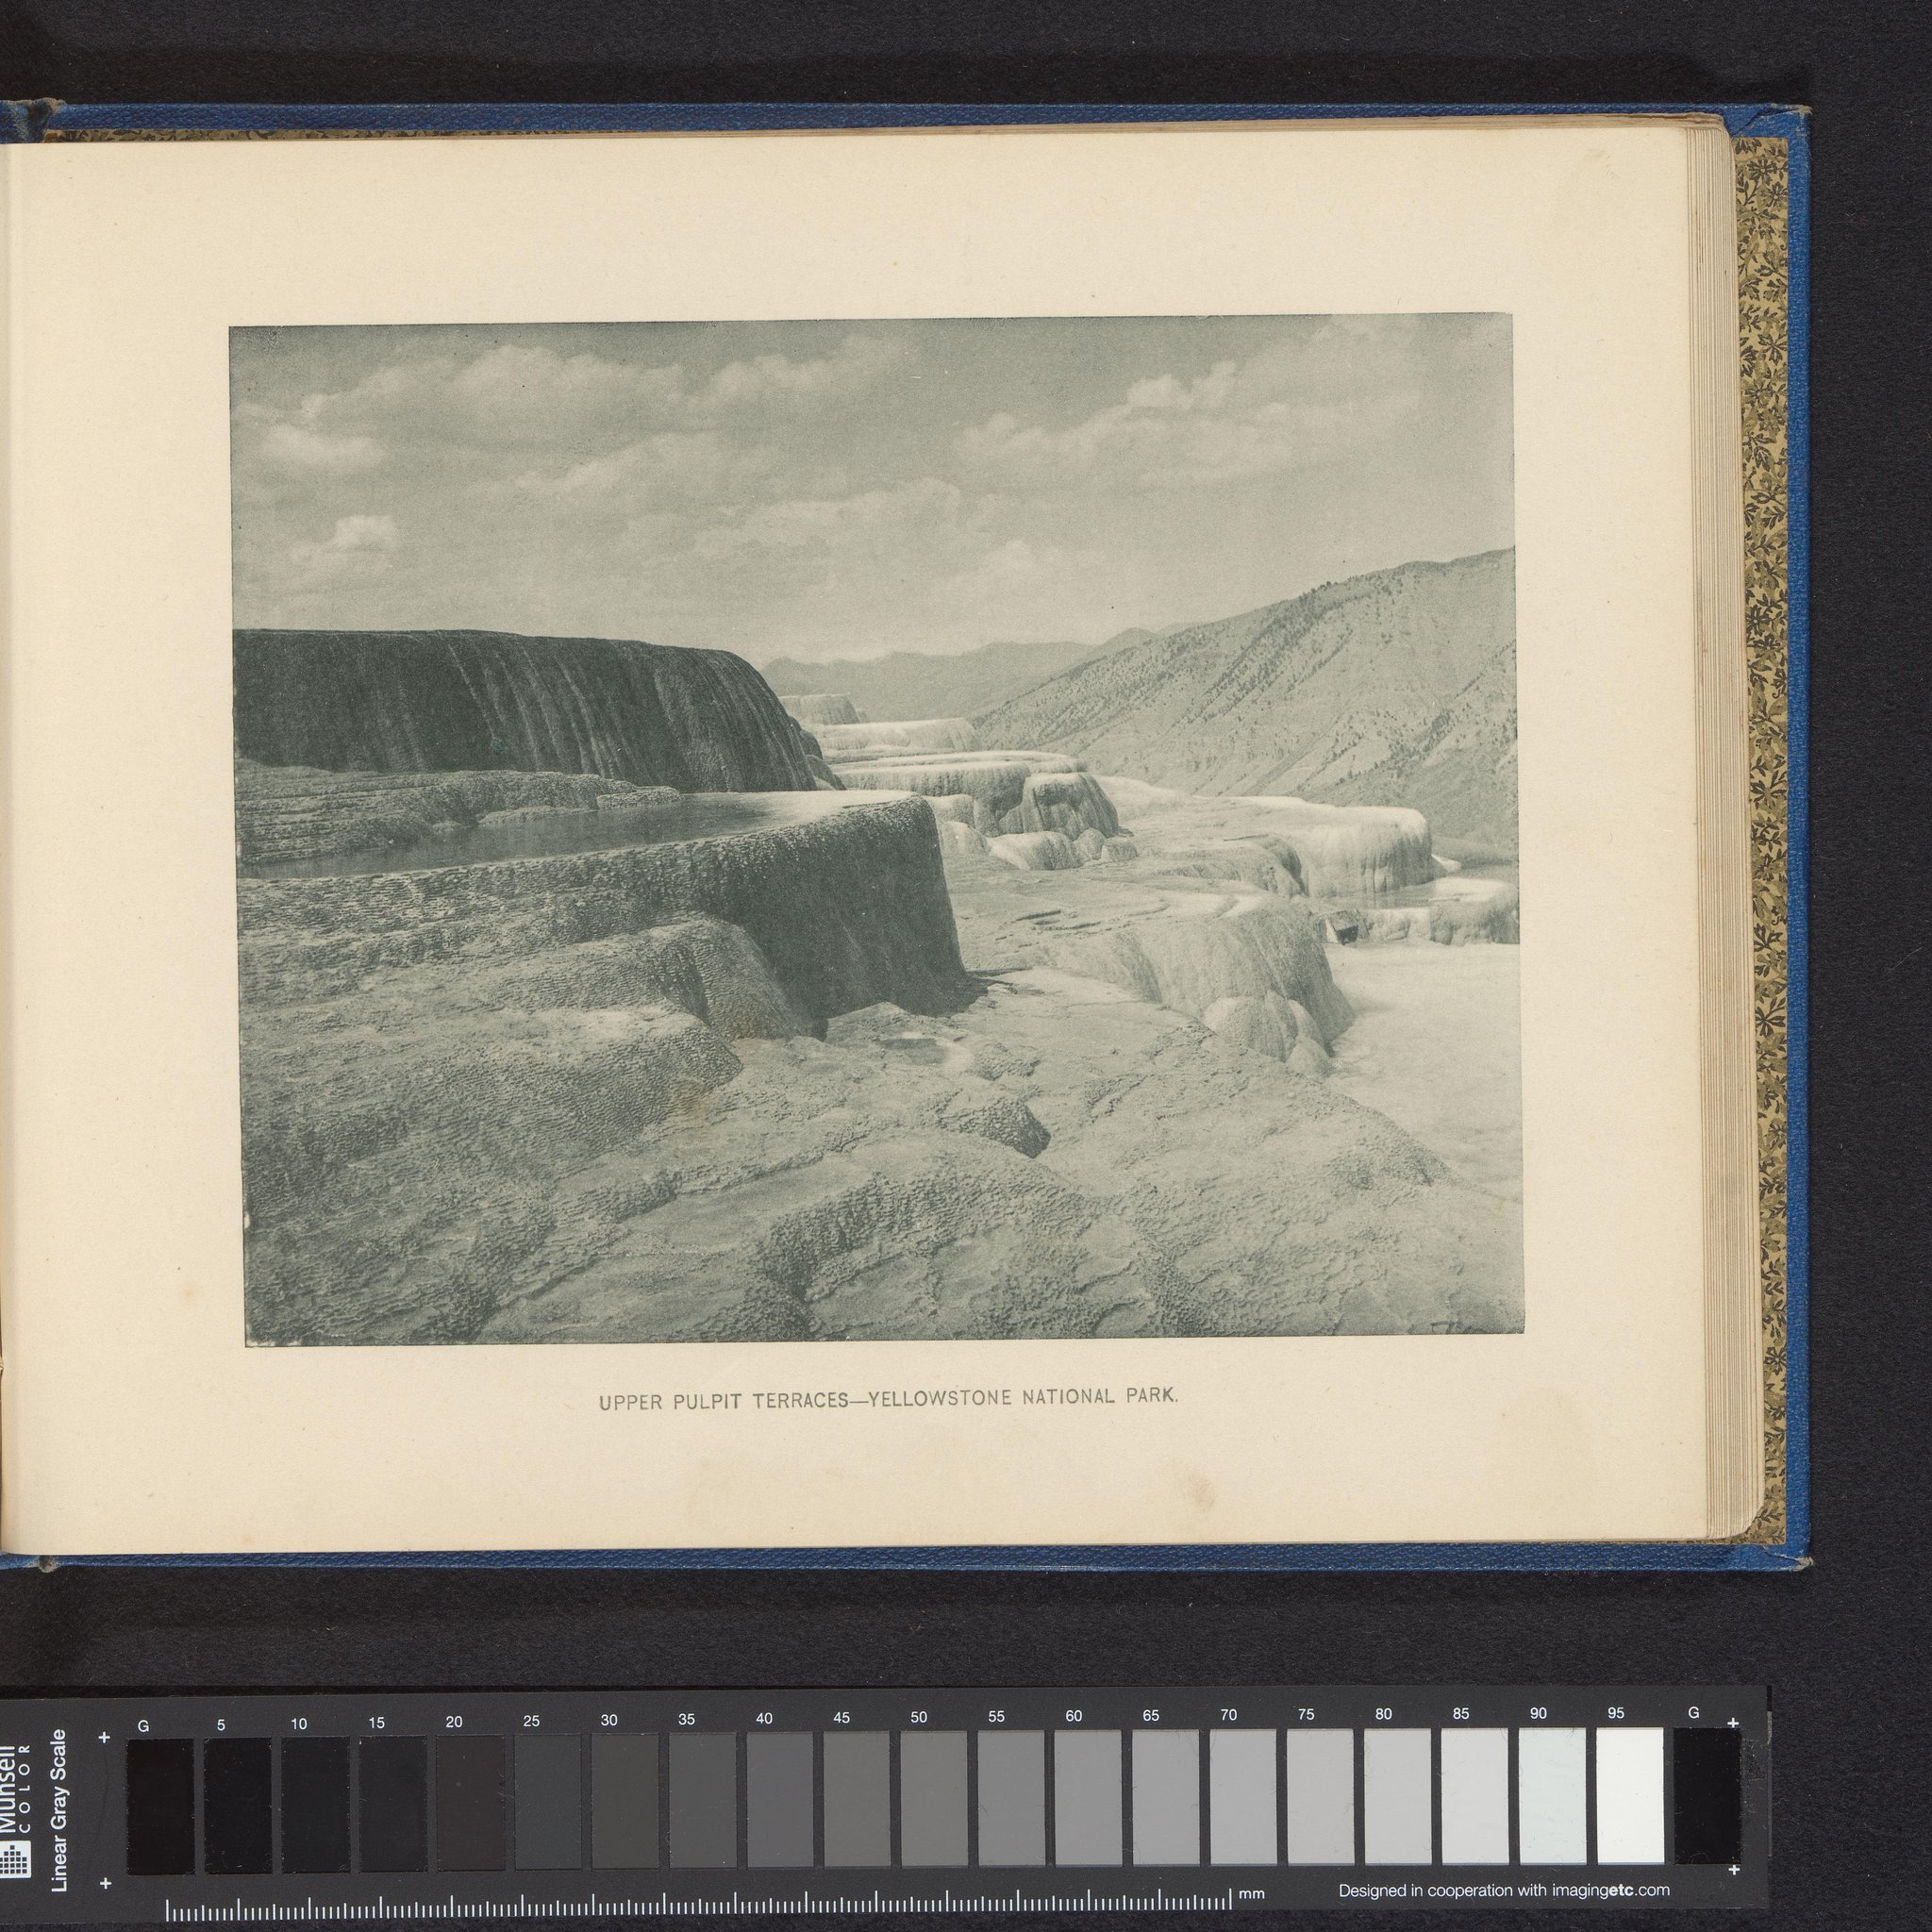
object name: photomechanical print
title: Upper Pulpit Terrace - Yellowstone National Park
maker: Anonymous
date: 1883-1893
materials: paper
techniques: photograph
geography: yellowstone national park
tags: watering-place, spa